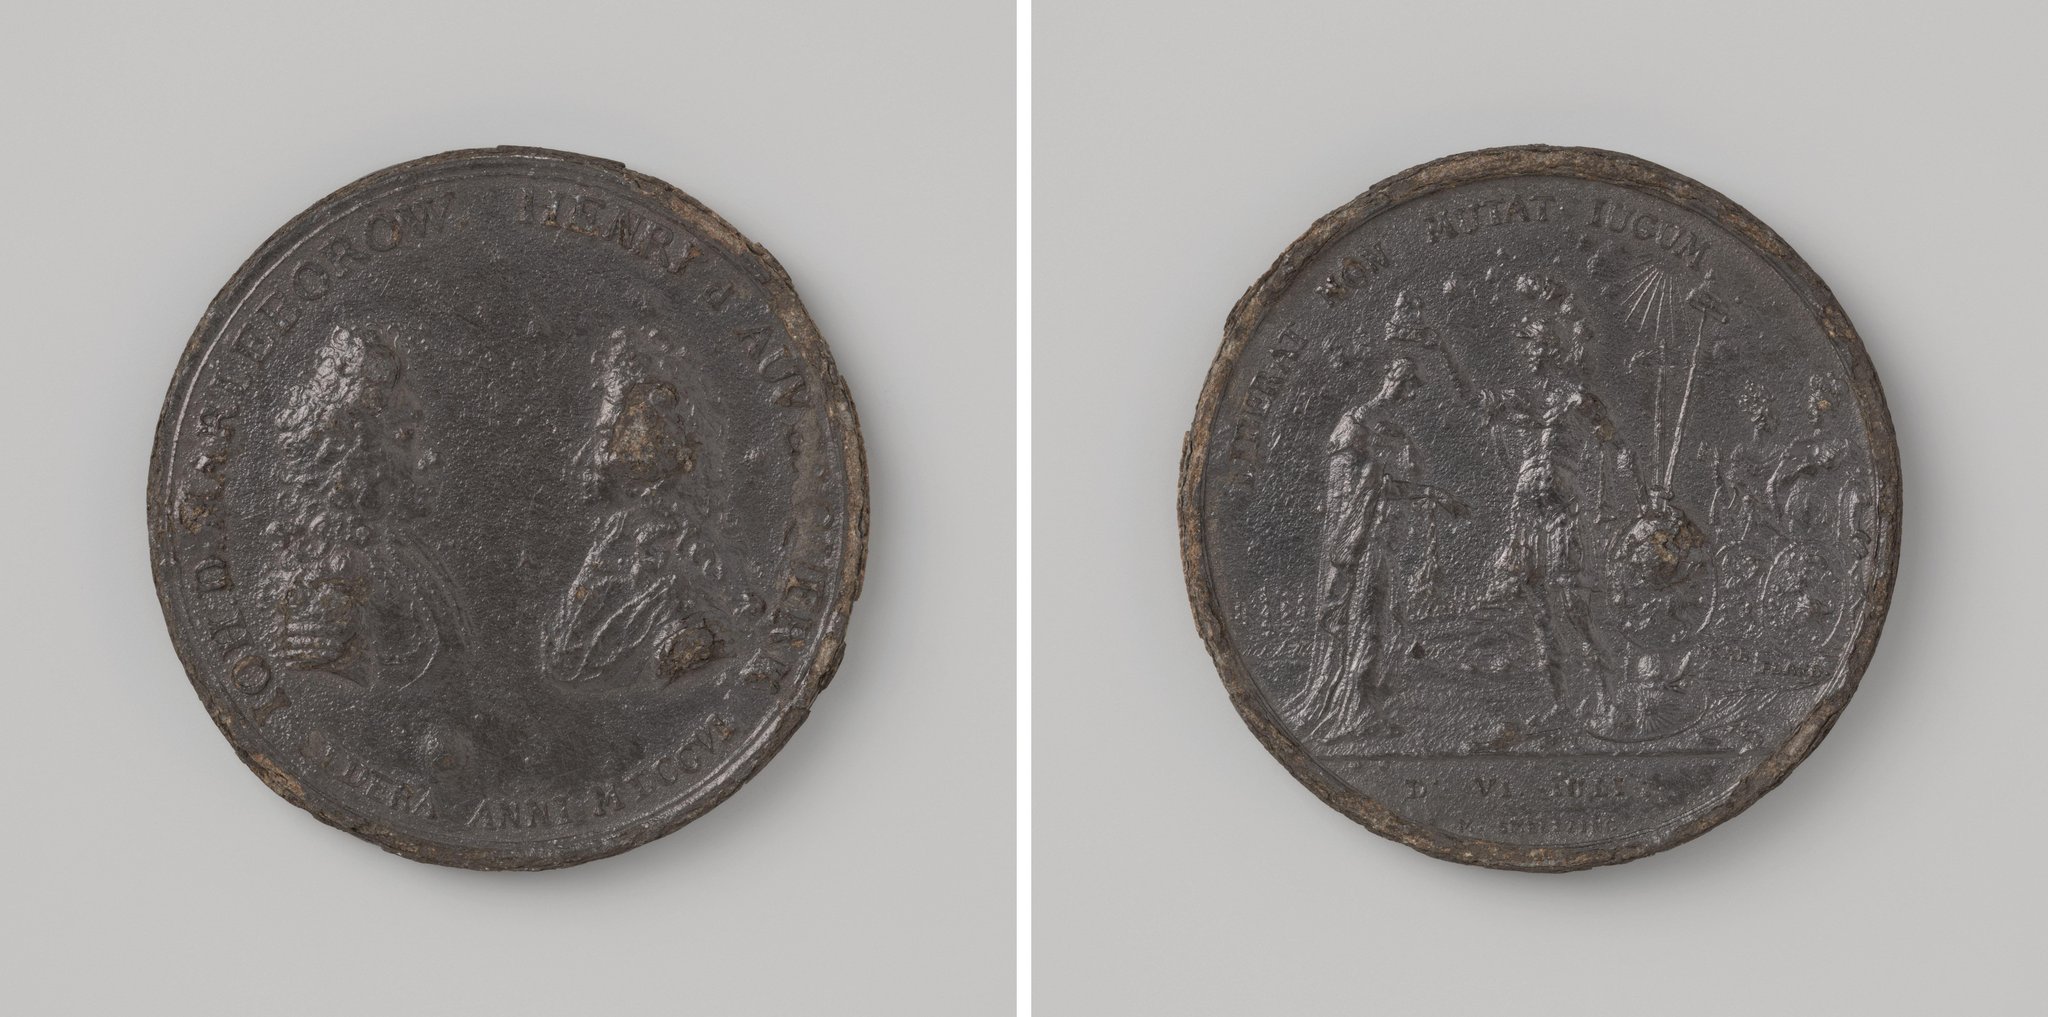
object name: history medal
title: Inname van Ostende 1706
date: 1706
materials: tin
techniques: casting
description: Gegoten tinnen penning, op de voorzijde de geharnaste borstbeelden van Marlborough en Ouwerkerk, elkaar aanziend, met omschrift, op de keerzijde de verpersoonlijkte Nederlandse Republiek die een vrijheidshoed schenkt aan Ostende, waarbij Vlaanderen en Brabant binnen bereik staan.